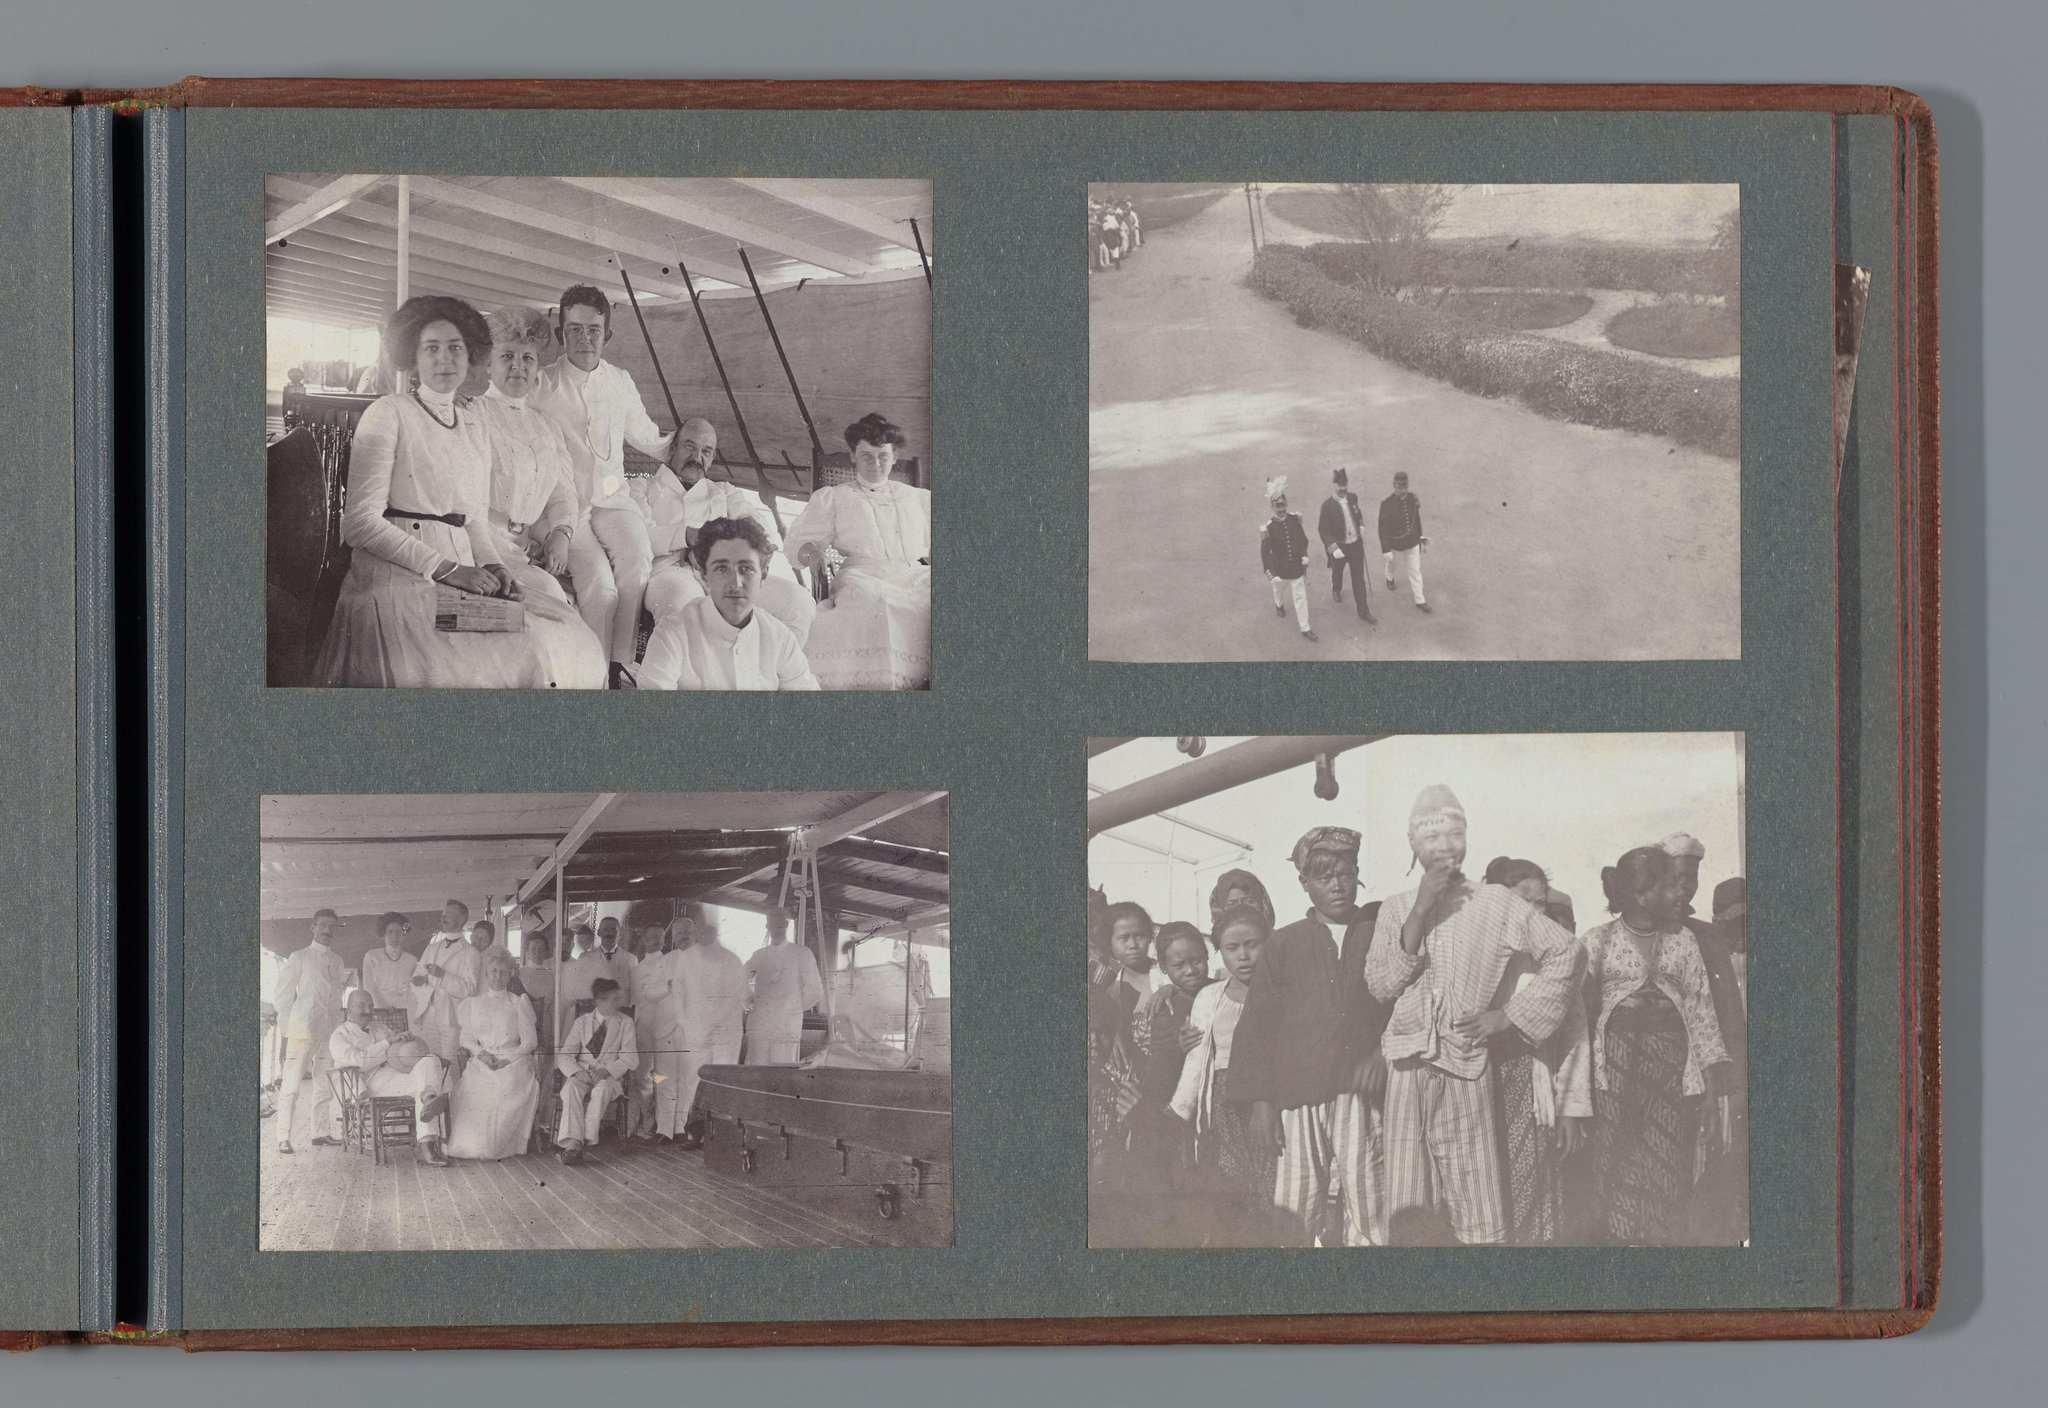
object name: photograph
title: Gezelschap bestaande uit zes mensen, aan boord van een schip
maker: Anonymous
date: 1905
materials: cardboard, paper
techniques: photography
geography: paramaribo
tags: suriname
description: Gezelschap bestaande uit zes mensen, aan boord van een schip. Onderdeel van fotoalbum 'Suriname'.